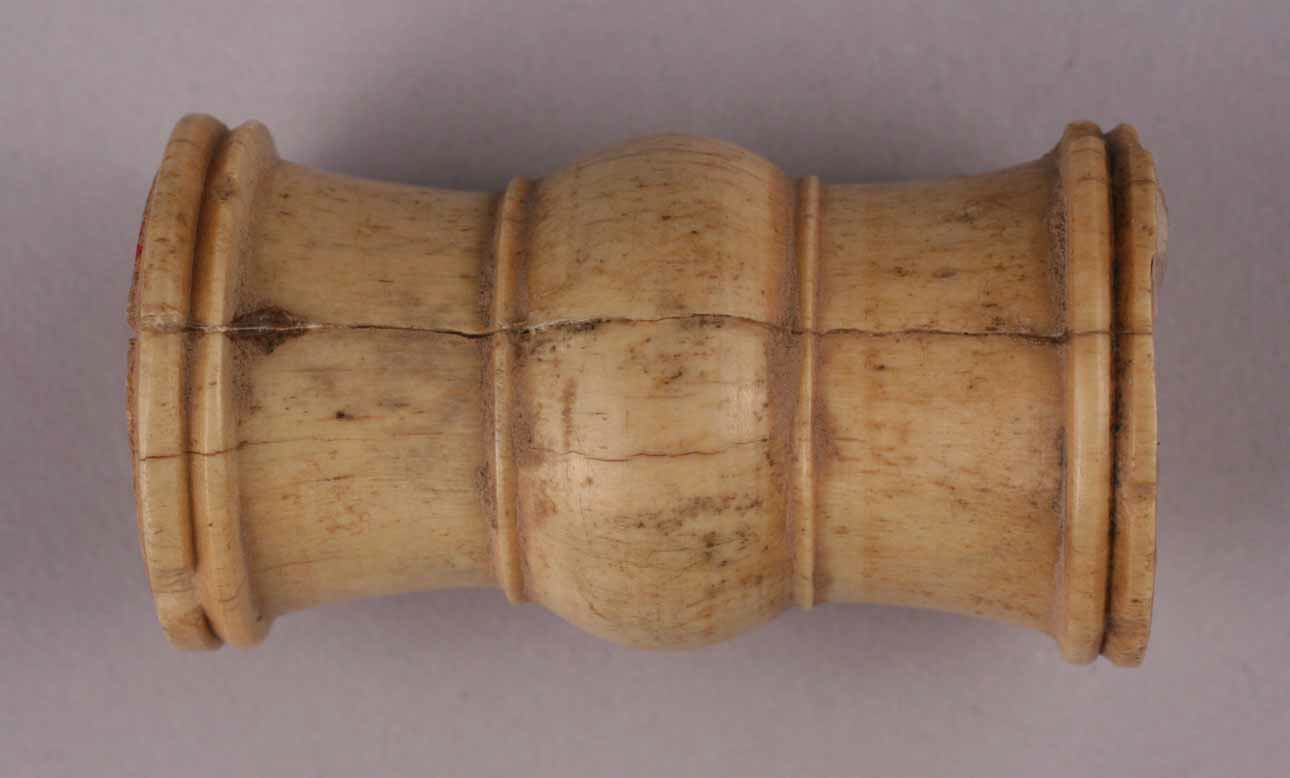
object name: a spool handle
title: Possibly a Spool Handle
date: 767-833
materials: bone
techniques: carving, incising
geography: iran